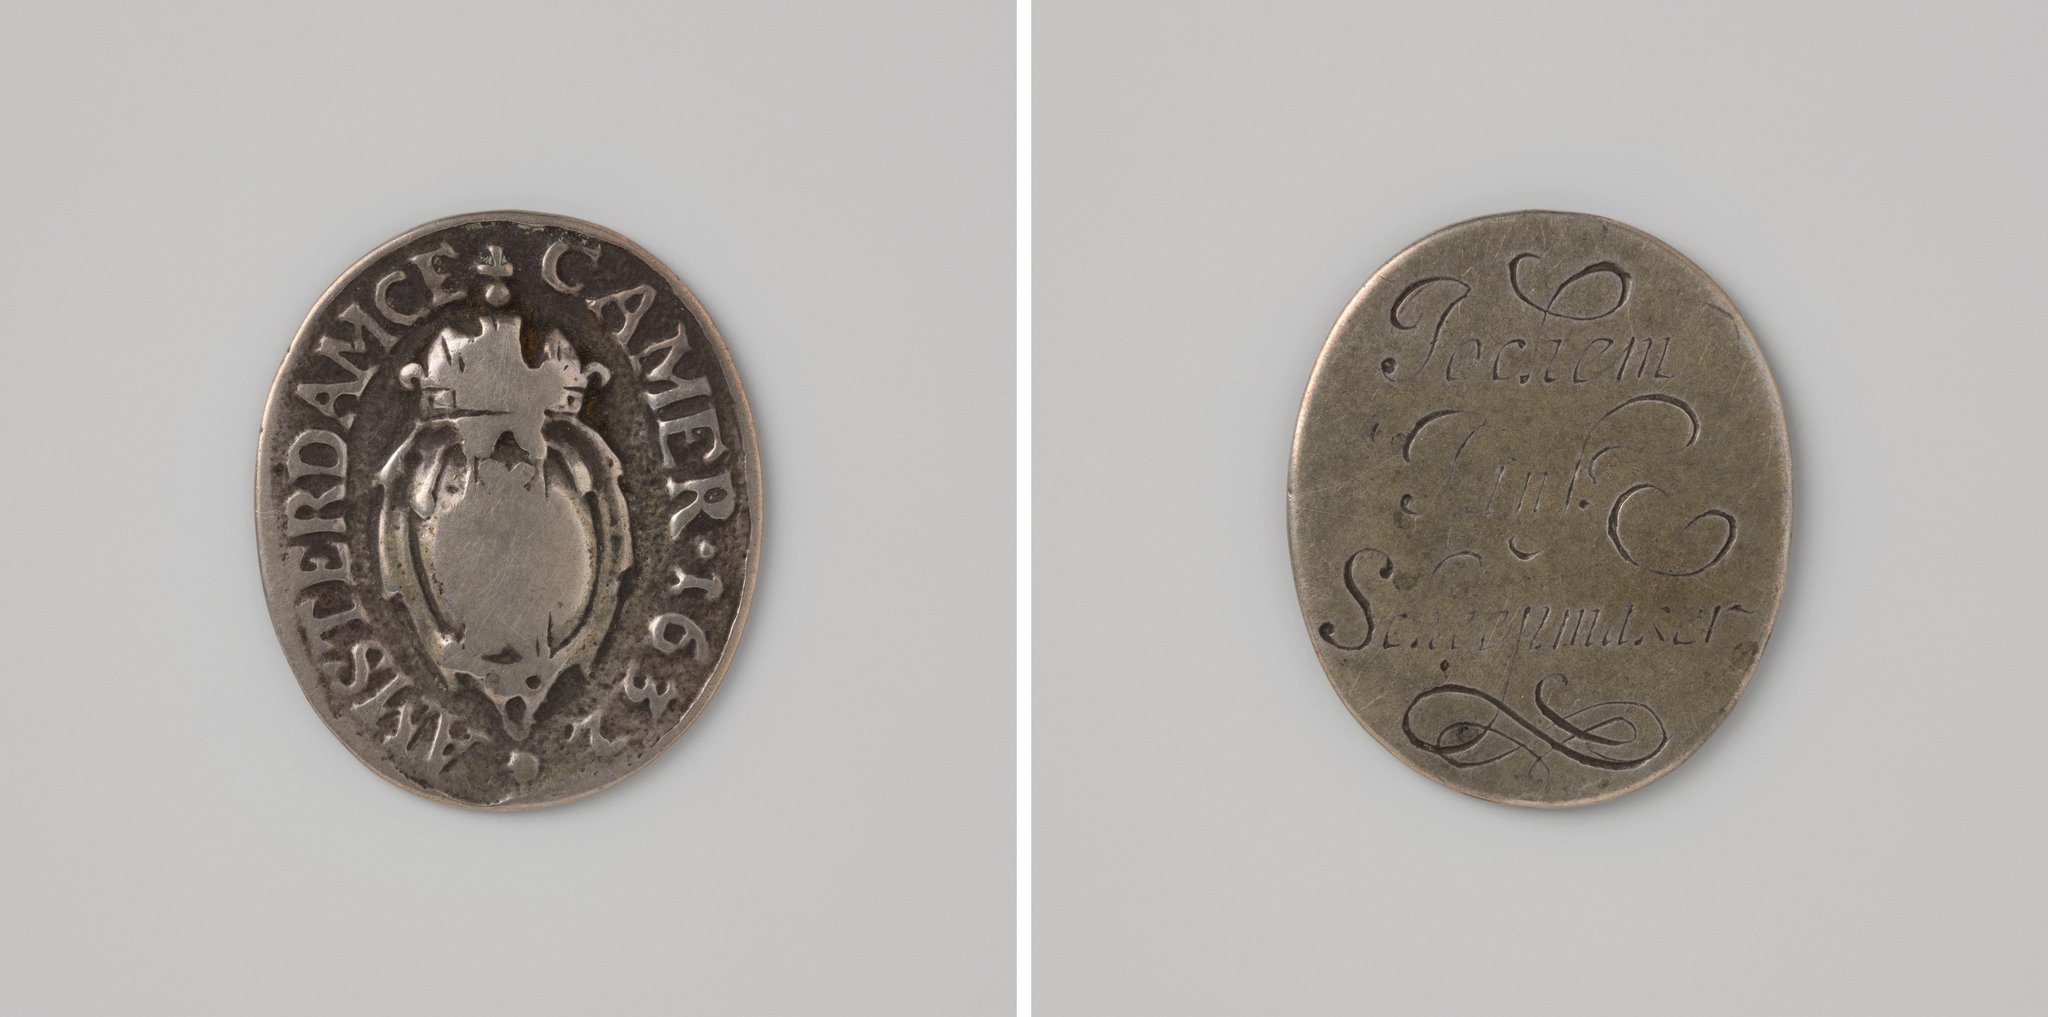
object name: history medal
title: Toegangspenning voor de Amsterdamse Rederijkerskamer 1632 op naam van Jochem Jansz Scheepmaker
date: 1632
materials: silver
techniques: casting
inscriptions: inscription: ‘Jochem / Jansz / Scheepmaker’, circumscription: ‘AMSTERDAMCE -CAMER.1632’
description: Ovale gegoten zilveren penning, op de voorzijde een gekroond ovaal schild met het Amsterdamse stadswapen, met omschrift, op de keerzijde de naam gegraveerd